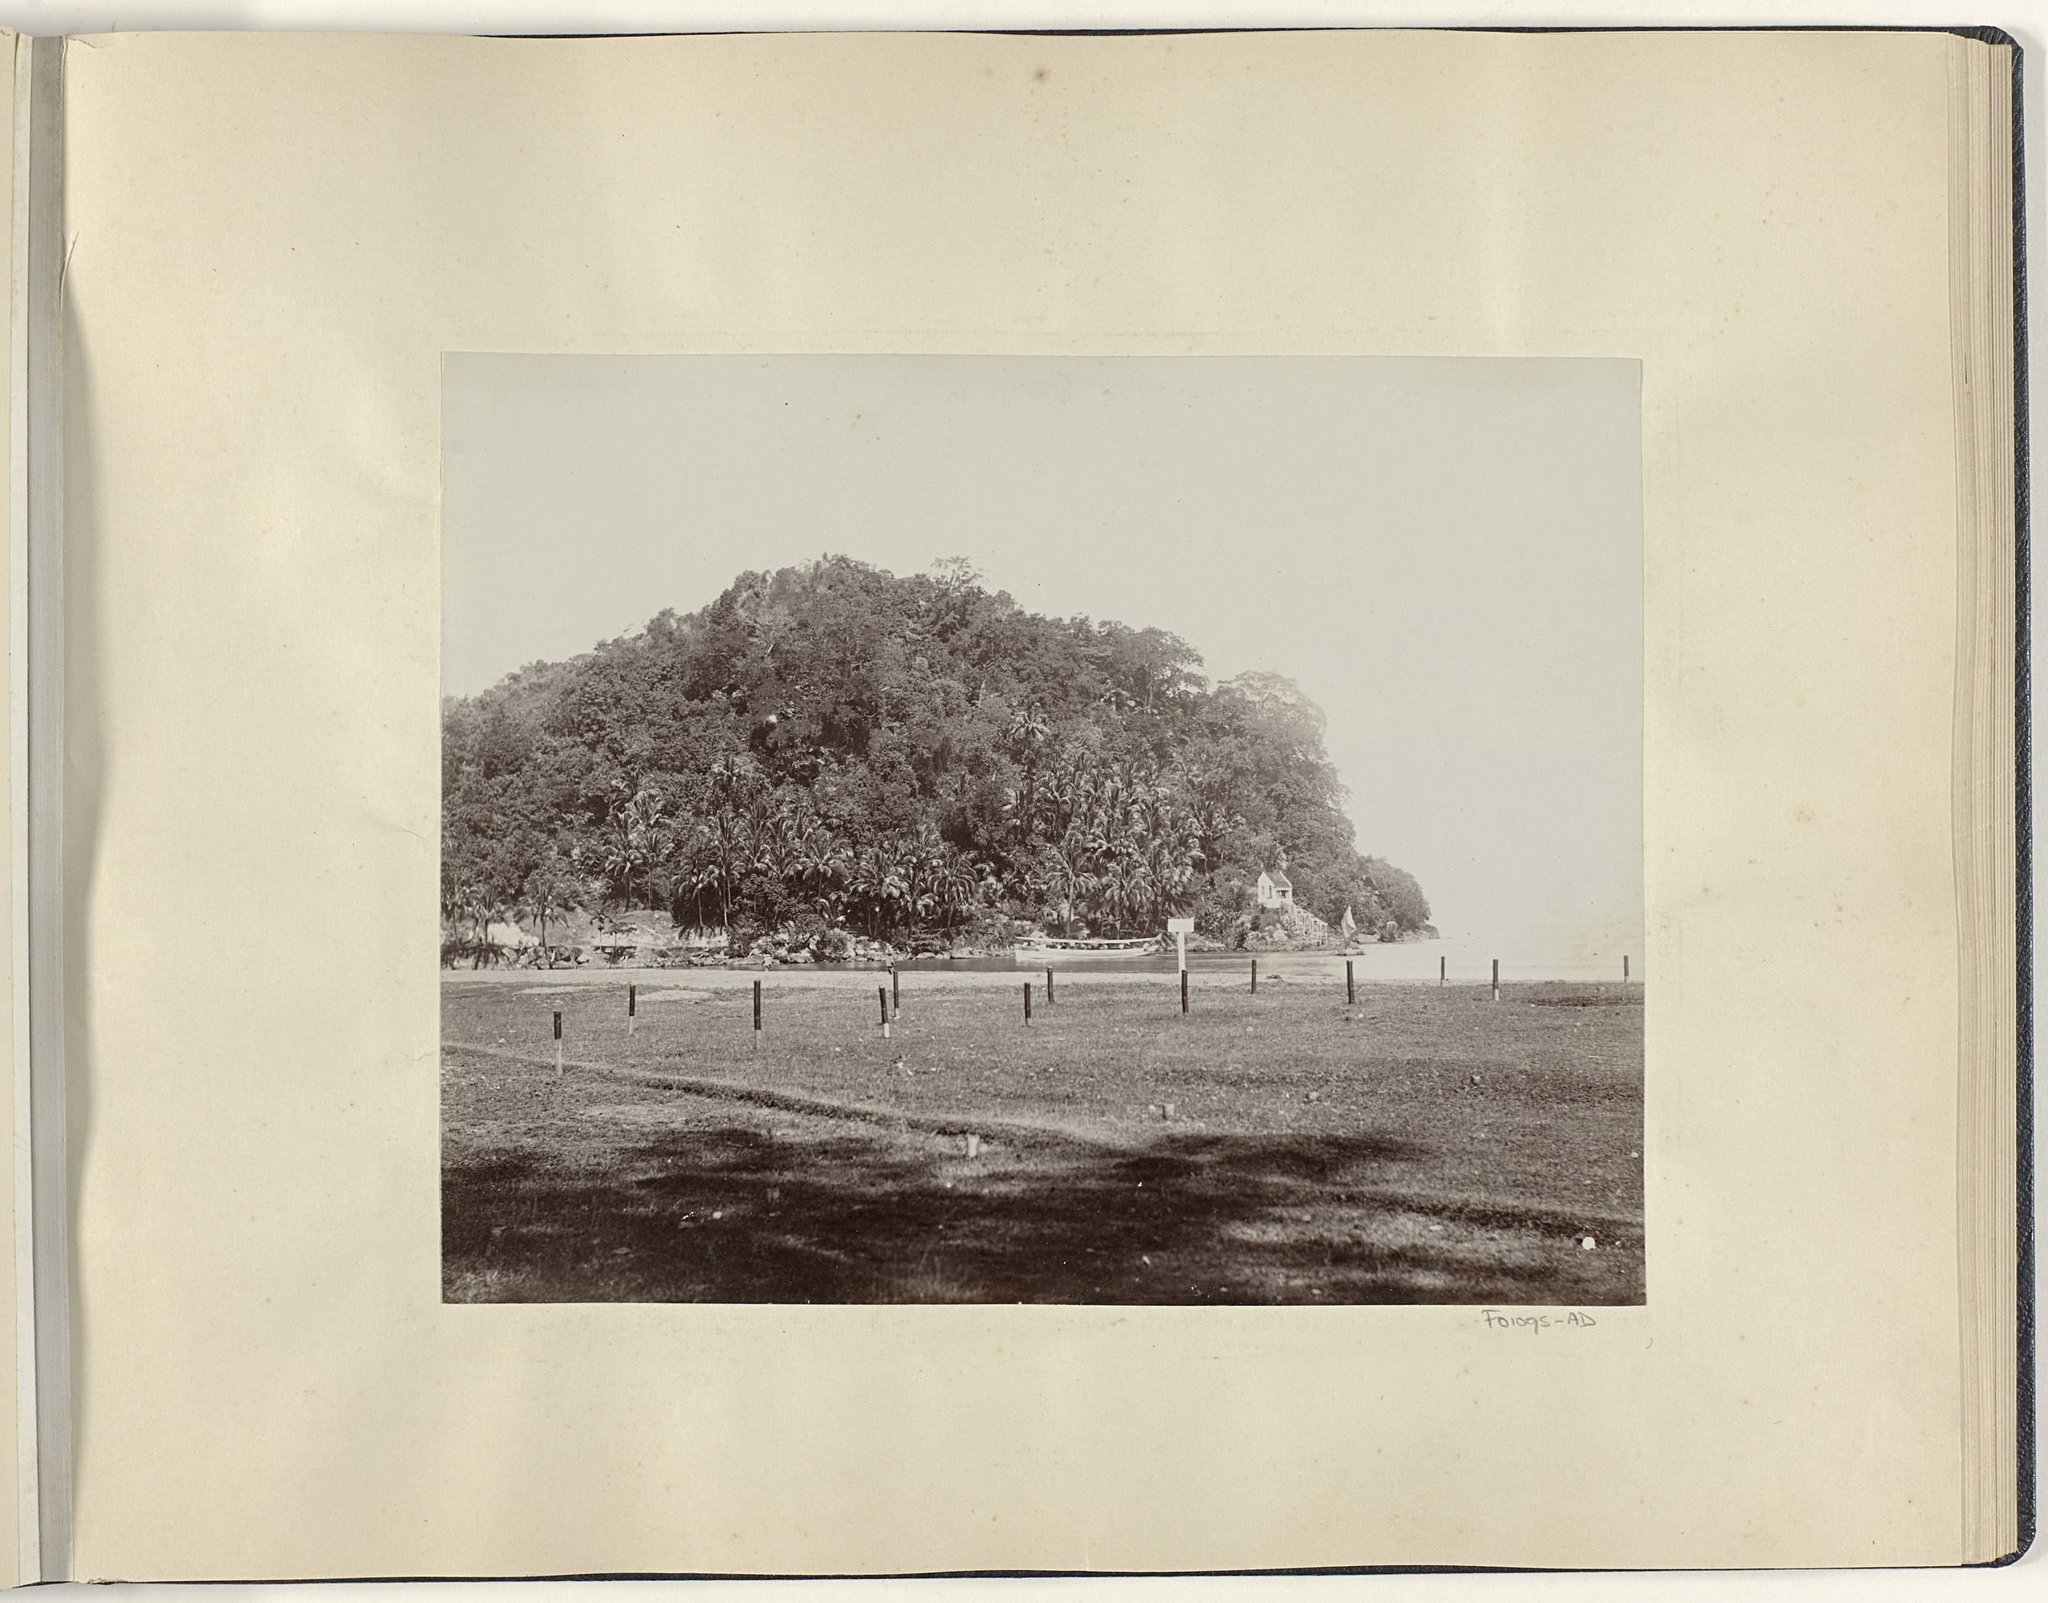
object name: photograph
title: Aanlegplaats bij een water in Nederlands-Indië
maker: Anonymous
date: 1895-1905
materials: paper, photographic support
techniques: albumen print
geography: dutch east indies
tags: harbour (+ view ~ vehicle, ship, etc.), dutch east indies, the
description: Onderdeel van Reisalbum met foto's van bezienswaardigheden in Italië, Zwitserland en Nederlands-Indië.